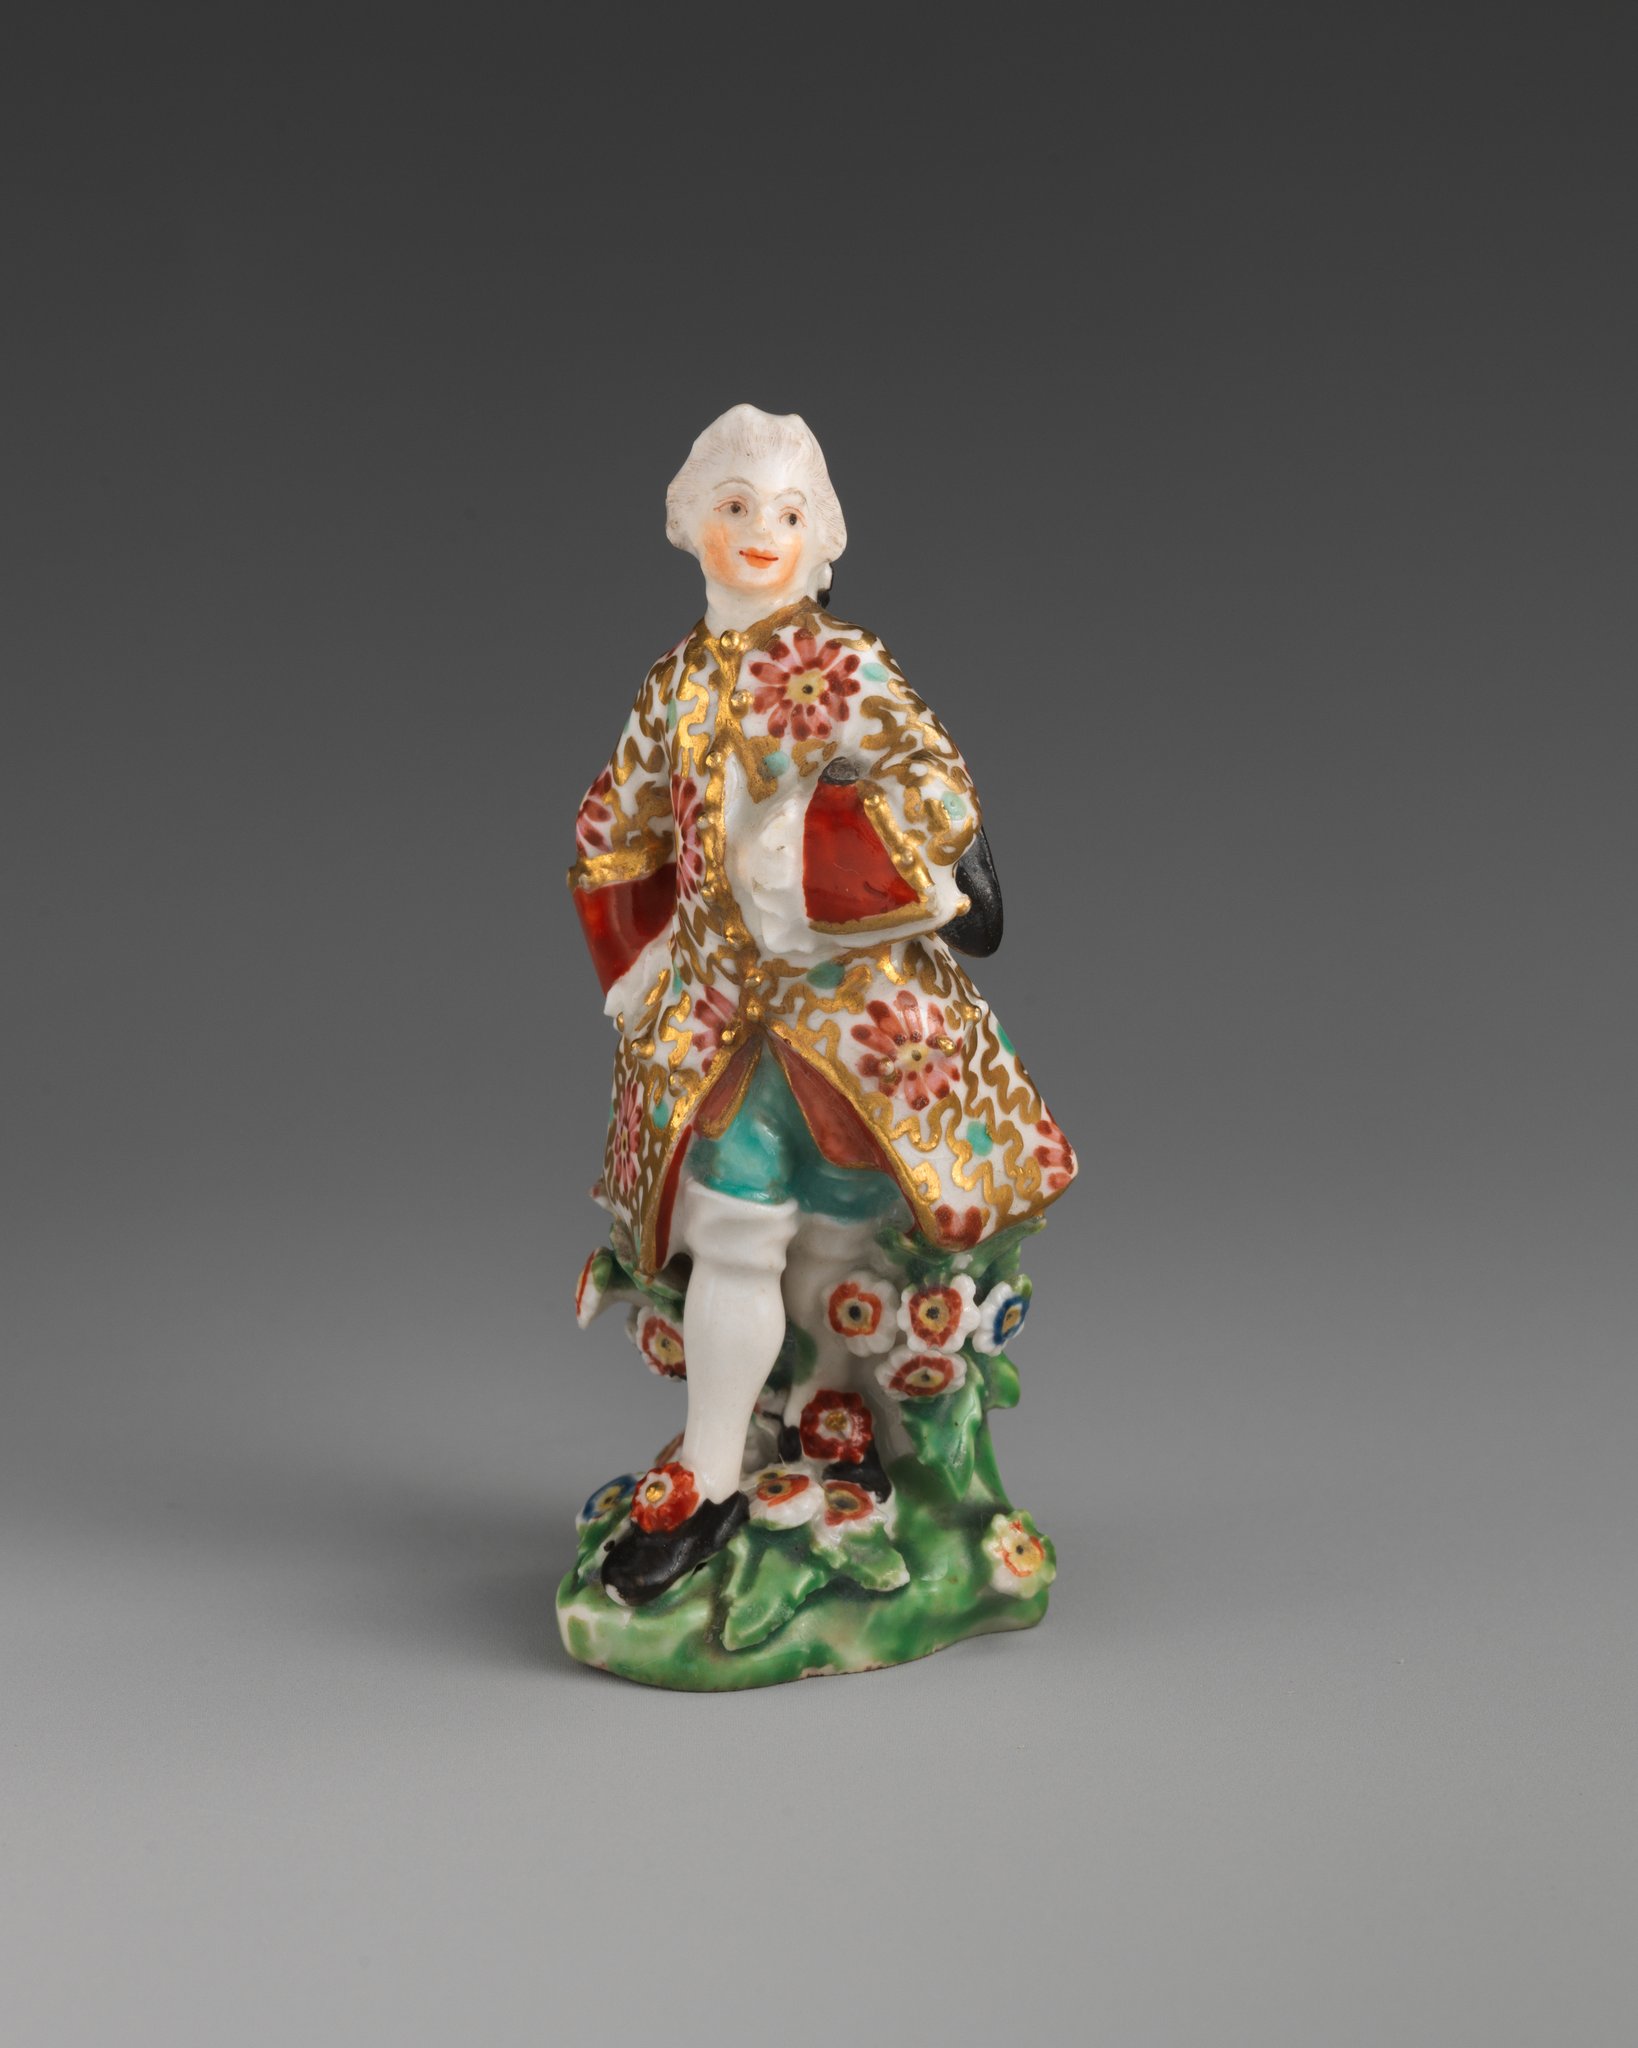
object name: toy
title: Gallant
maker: derby porcelain manufactory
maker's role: factory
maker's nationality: british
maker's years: 1751-1785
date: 1765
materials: soft paste porcelain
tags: men